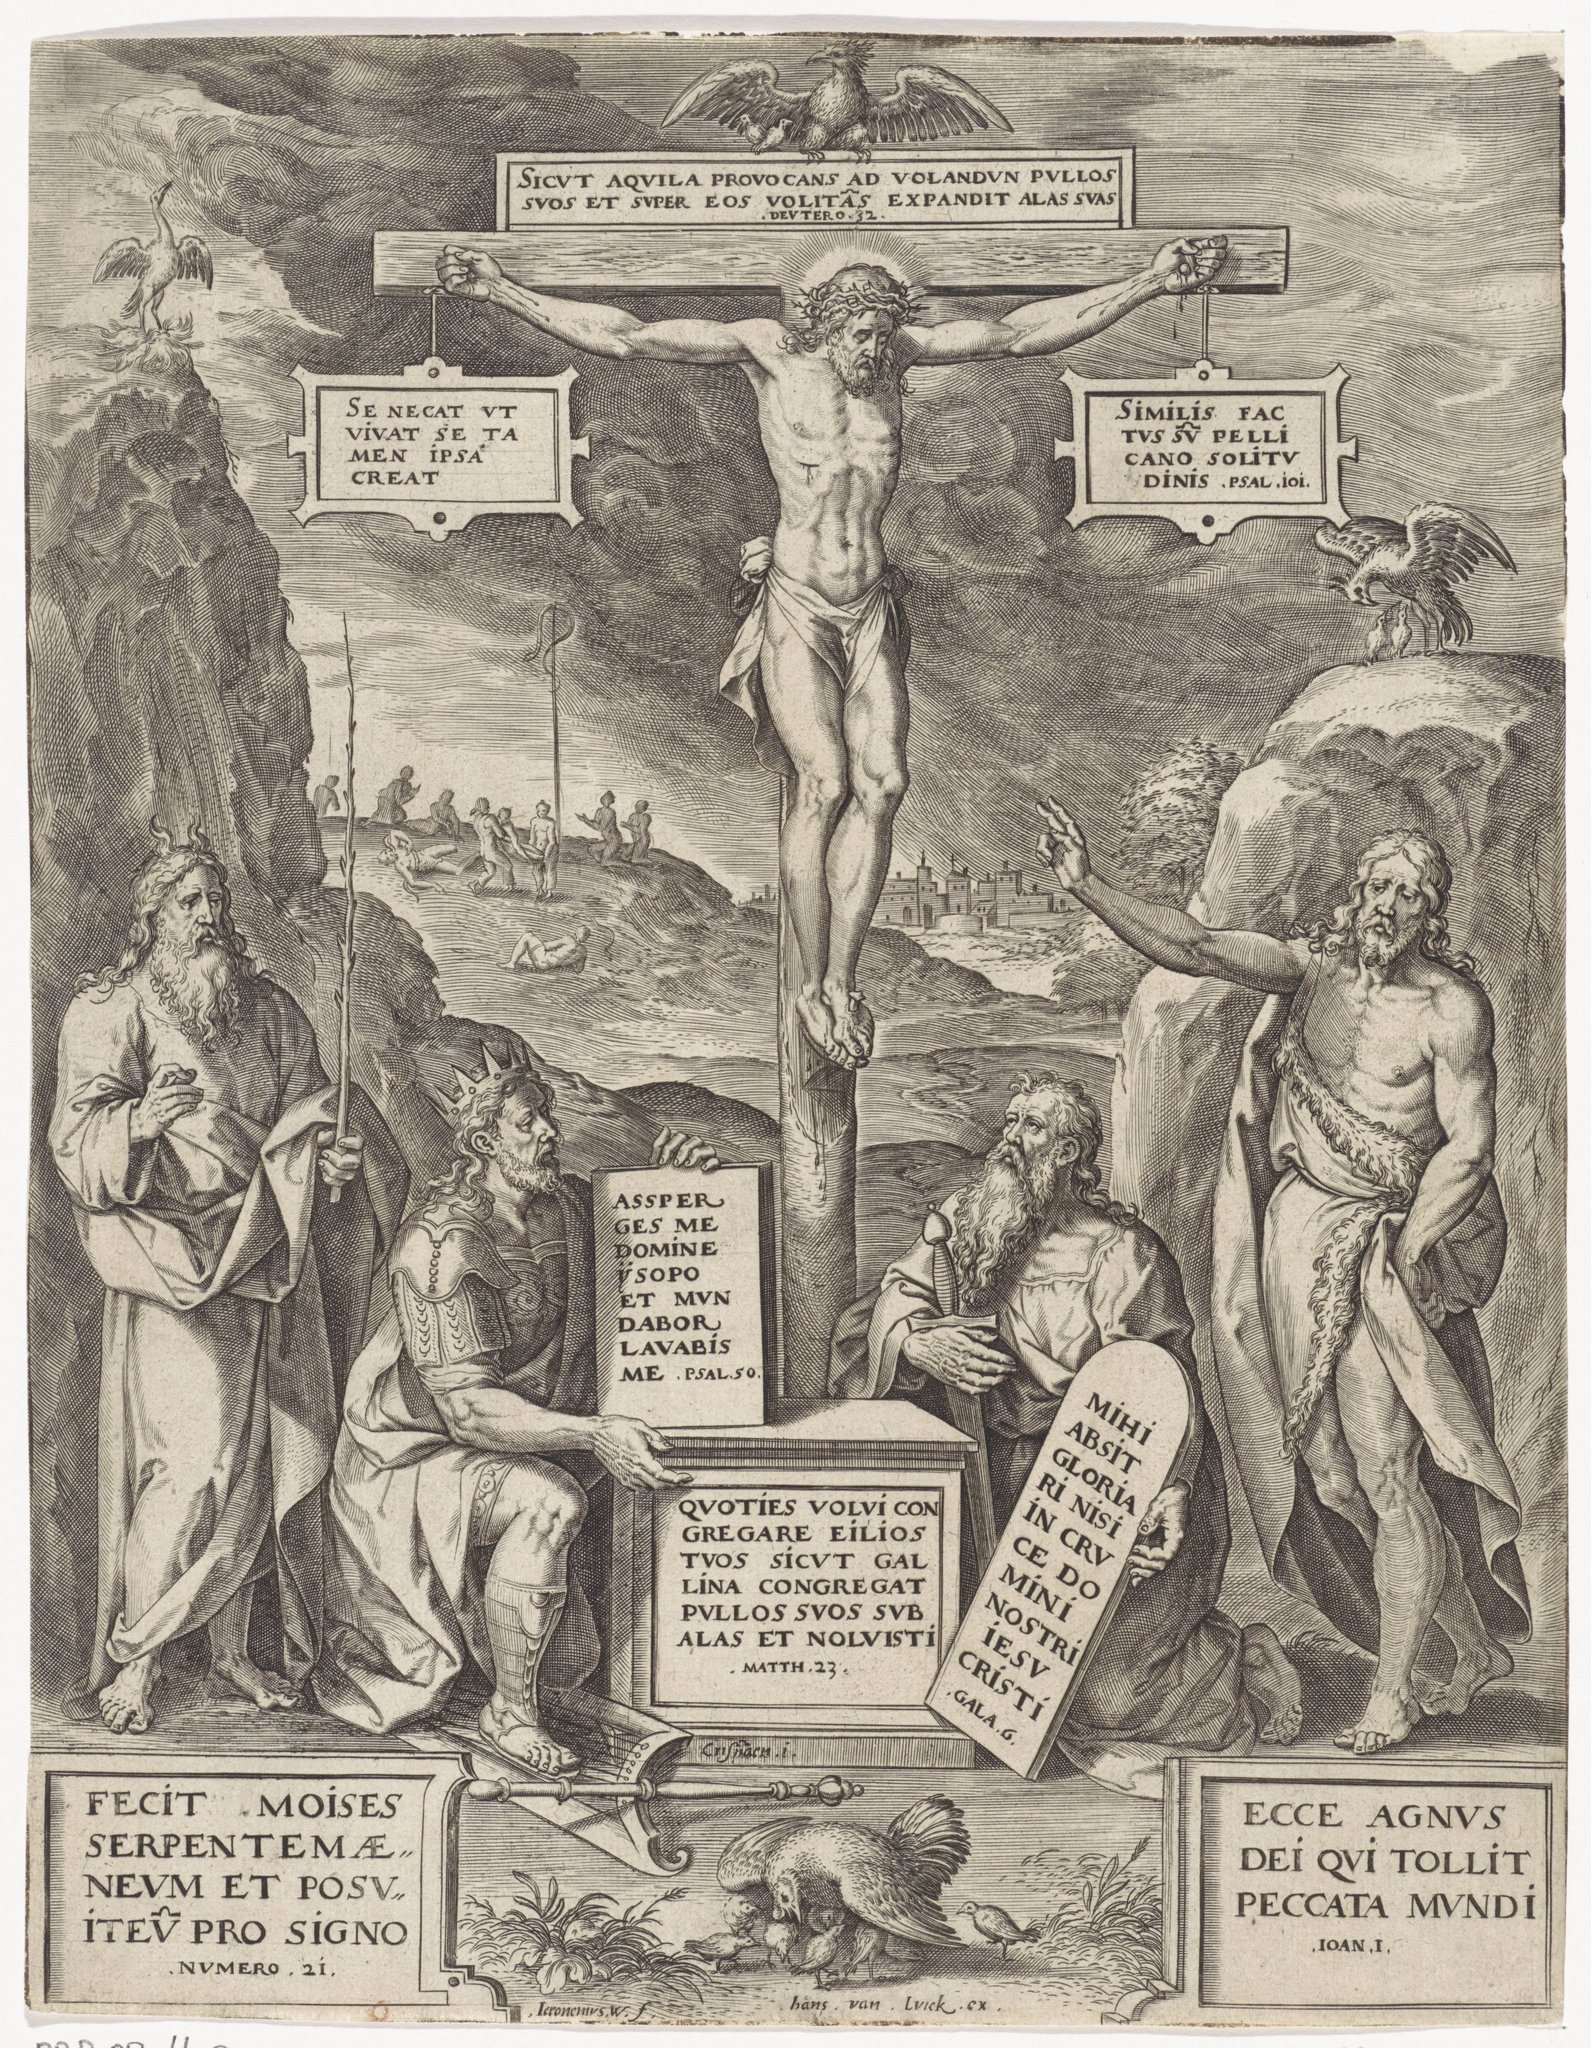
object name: print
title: Allegorie op de opstanding van Christus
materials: paper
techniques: engraving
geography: antwerp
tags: john the baptist; possible attributes: book, reed cross, baptismal cup, honeycomb, lamb, staff, predatory birds: eagle, fowl (cock, hen, chicken, etc.) (+ feeding and care of young), symbolic representations of the resurrection, david (not in biblical context); possible attributes: crown, harp, symbols of christ ~ animals, moses (not in biblical context); possible attributes: rays of light or horns on his head, rod, tables of the law, a serpent of brass is made and is set on a pole, fabulous animals ~ birds: phoenix, the apostle paul of tarsus; possible attributes: book, scroll, sword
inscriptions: collector's mark: Lugt 2228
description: Christus hangt aan het kruis. Aan de voet van het kruis Mozes en koning David (links) en Paulus en Johannes de Doper (rechts). Rondom diverse verwijzingen naar de opstanding van Christus: boven het kruis en aan de rechterzijde een adelaar, onderaan een kip met haar kuikens, en aan de linkerzijde een feniks. Op de achtergrond de oprichting van de koperen slang door Mozes. Links en rechtsonder Bijbelcitaten uit Num. 21 en Joh. 1 in het Latijn.